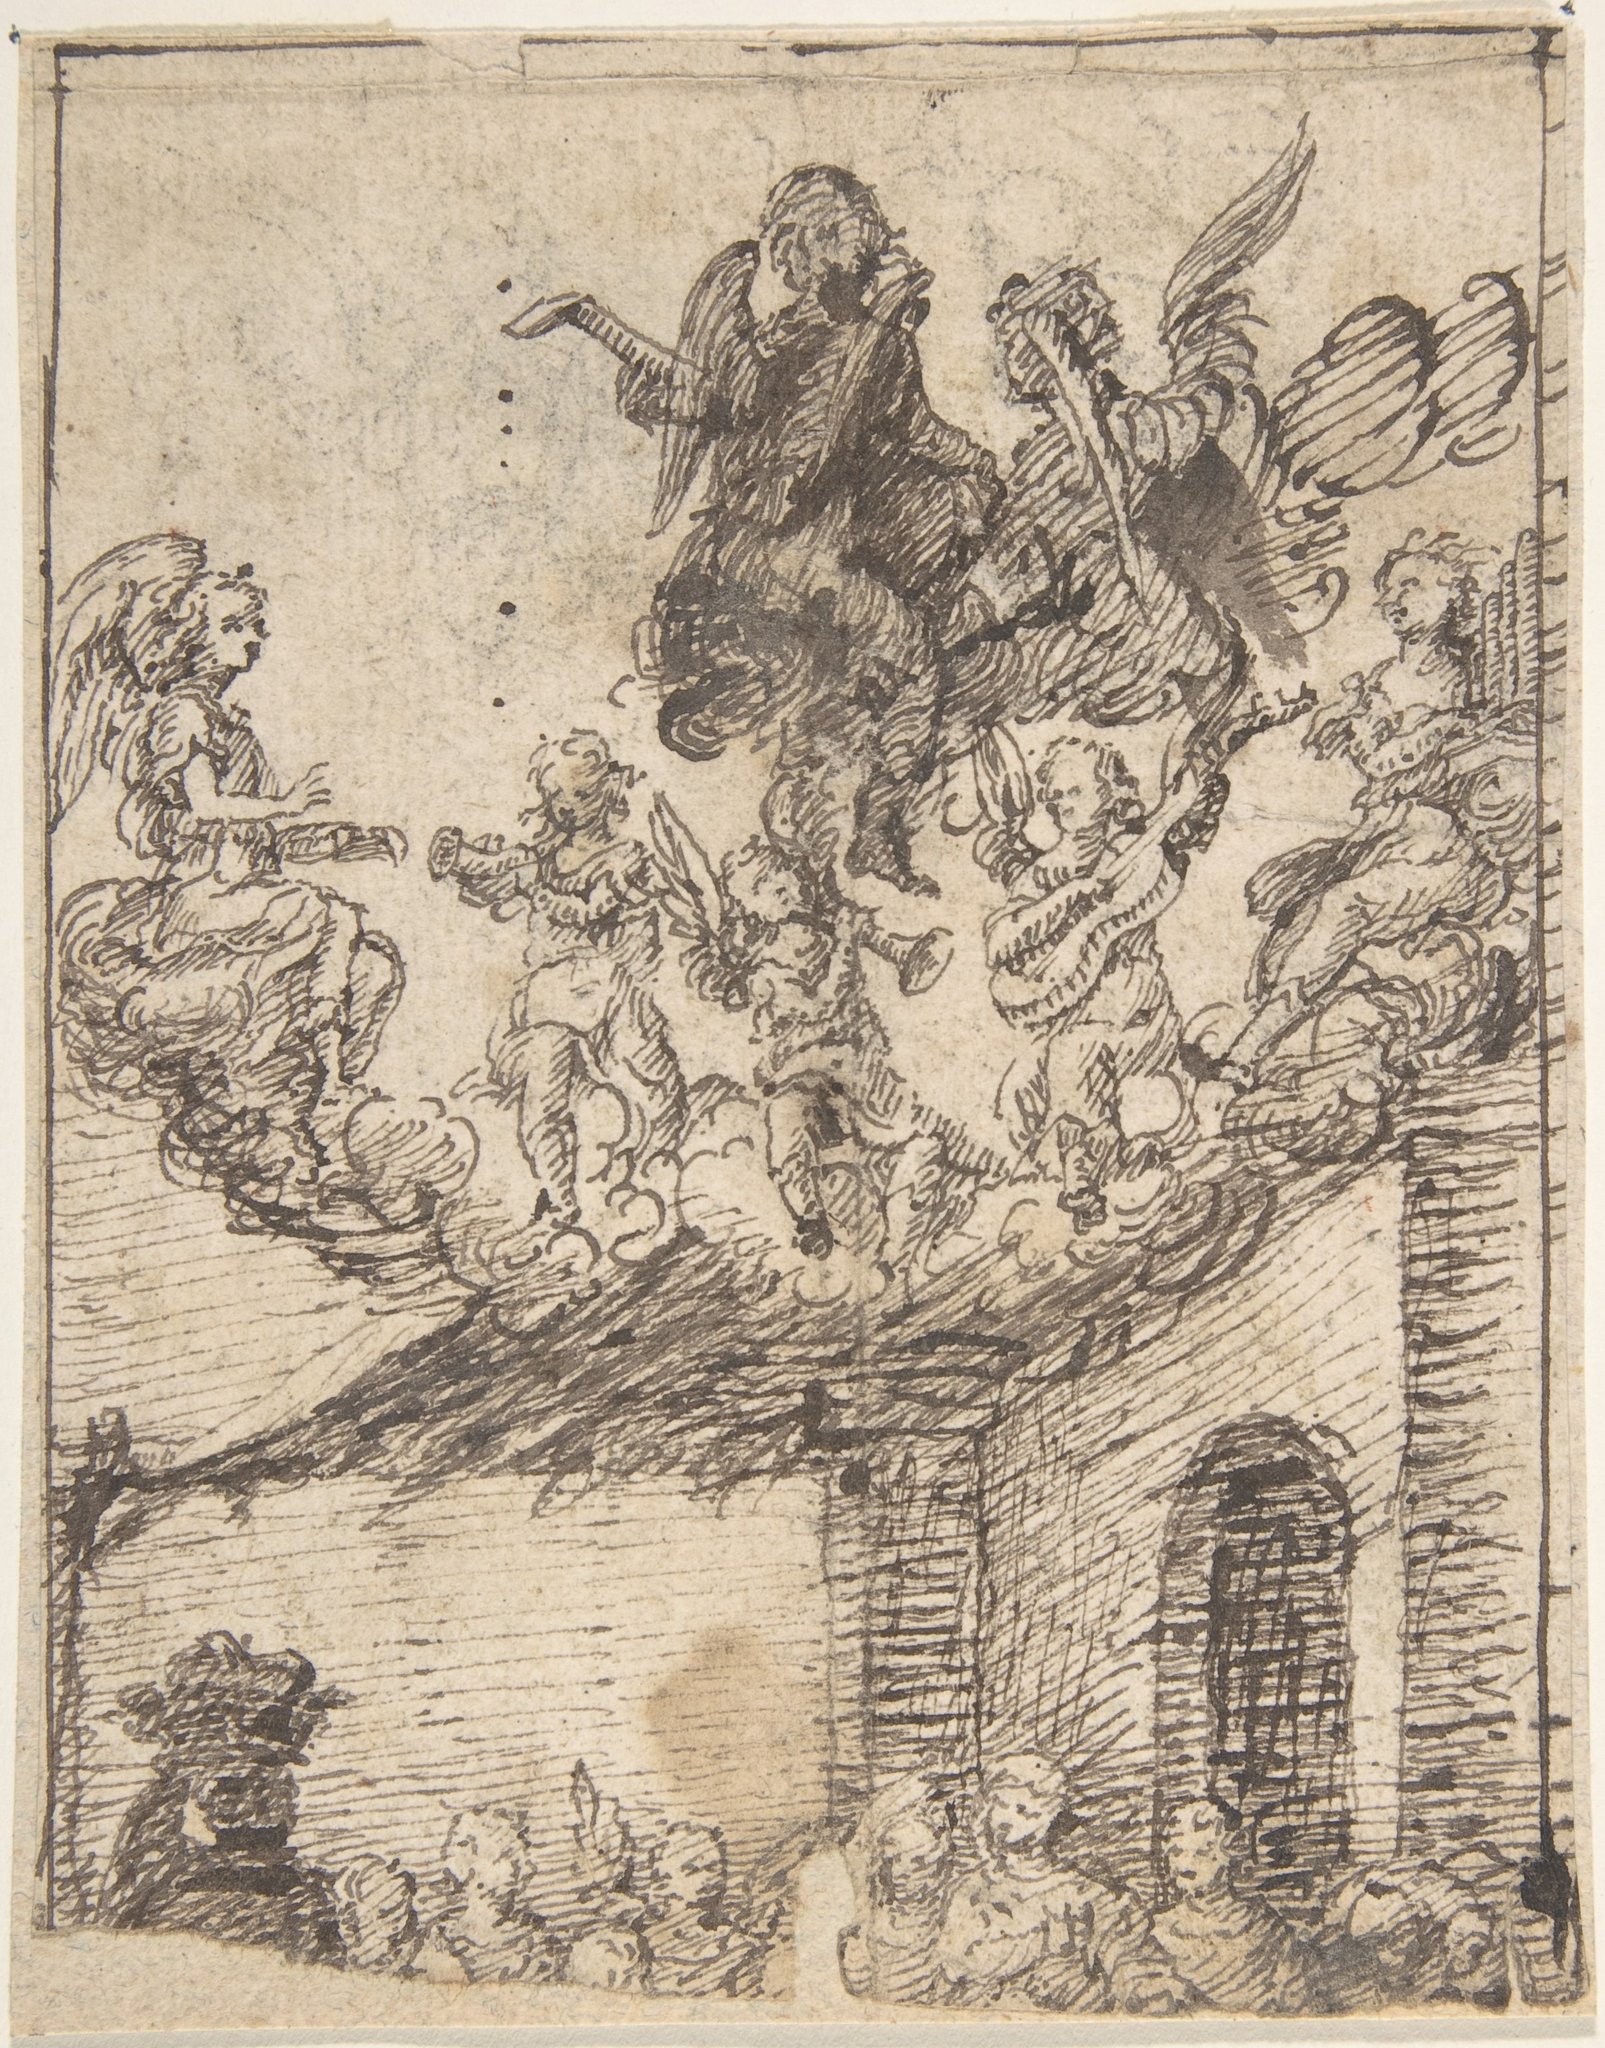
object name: drawing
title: Fragment of Nativity Scene with Music-Making Angels on Clouds Above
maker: anonymous, spanish, school of seville, 17th century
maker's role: artist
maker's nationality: spanish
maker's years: 1600-1700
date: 1601-1700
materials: chalk, ink, paper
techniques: brush, pen, drawing, wash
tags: angels,nativity